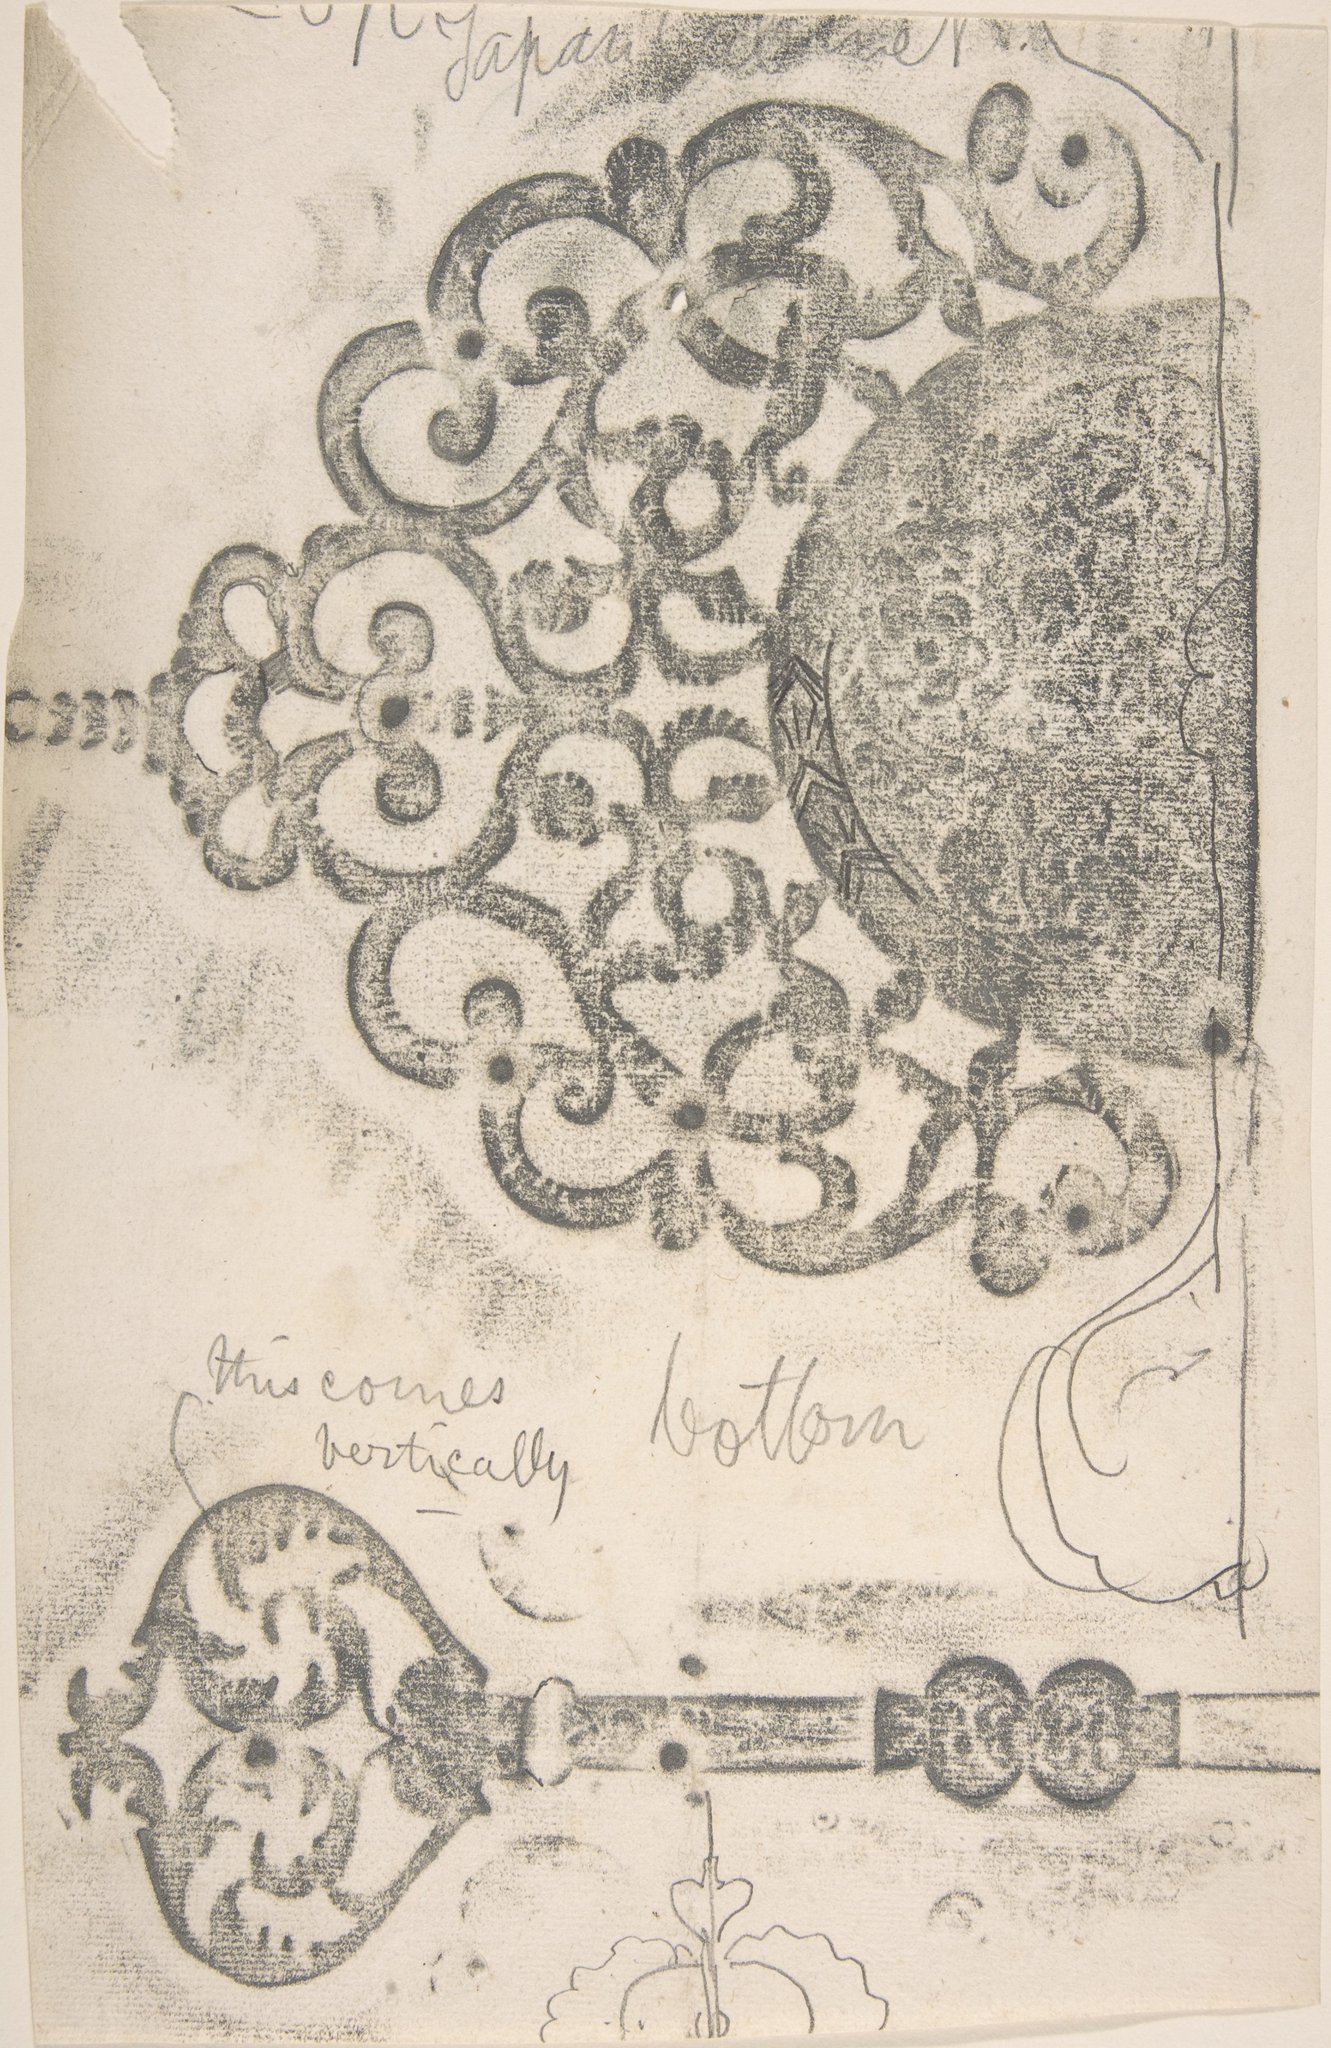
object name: drawing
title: Rubbings of Metalwork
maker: richardson ellson & co.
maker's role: artist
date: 1880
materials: charcoal, graphite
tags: ornament